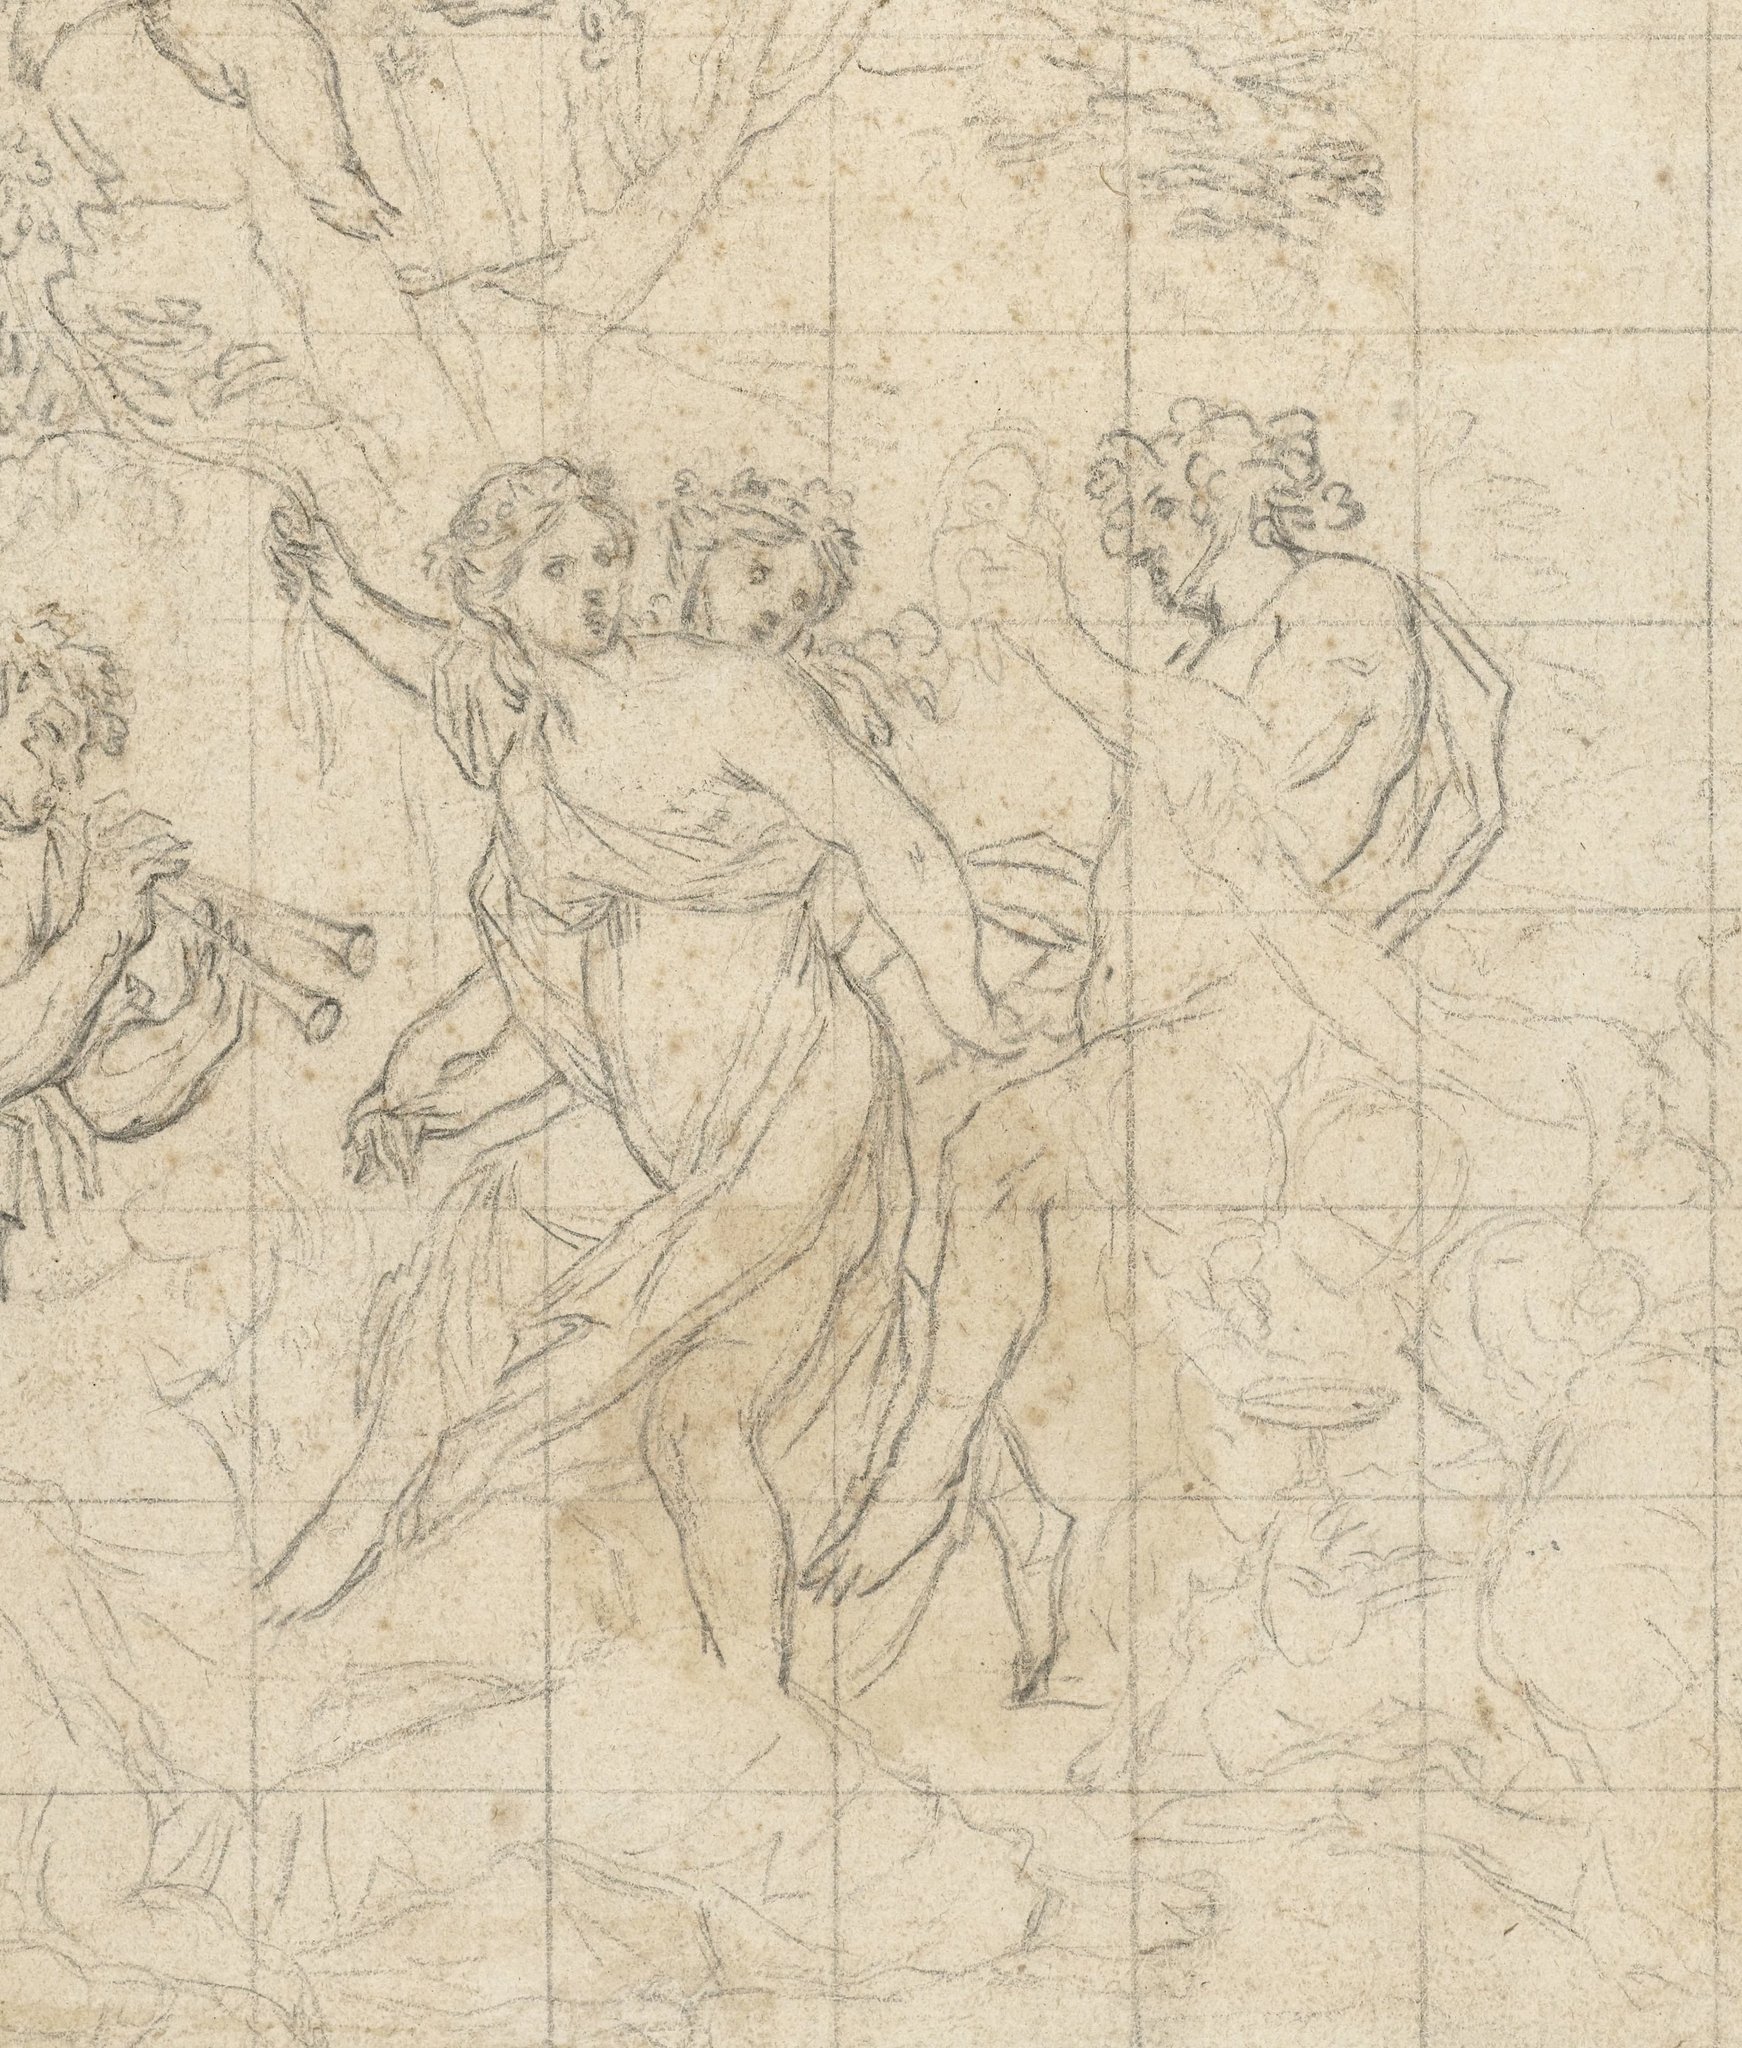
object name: drawing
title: Dansende saters en nimfen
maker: andrea sacchi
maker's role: draughtsman, painter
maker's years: 1599-1661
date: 1609-1661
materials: chalk, paper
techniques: drawing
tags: satyrs, fauns, sileni, one person playing wind instrument, group dancing, types of nymphs, flute, aulos, tibia